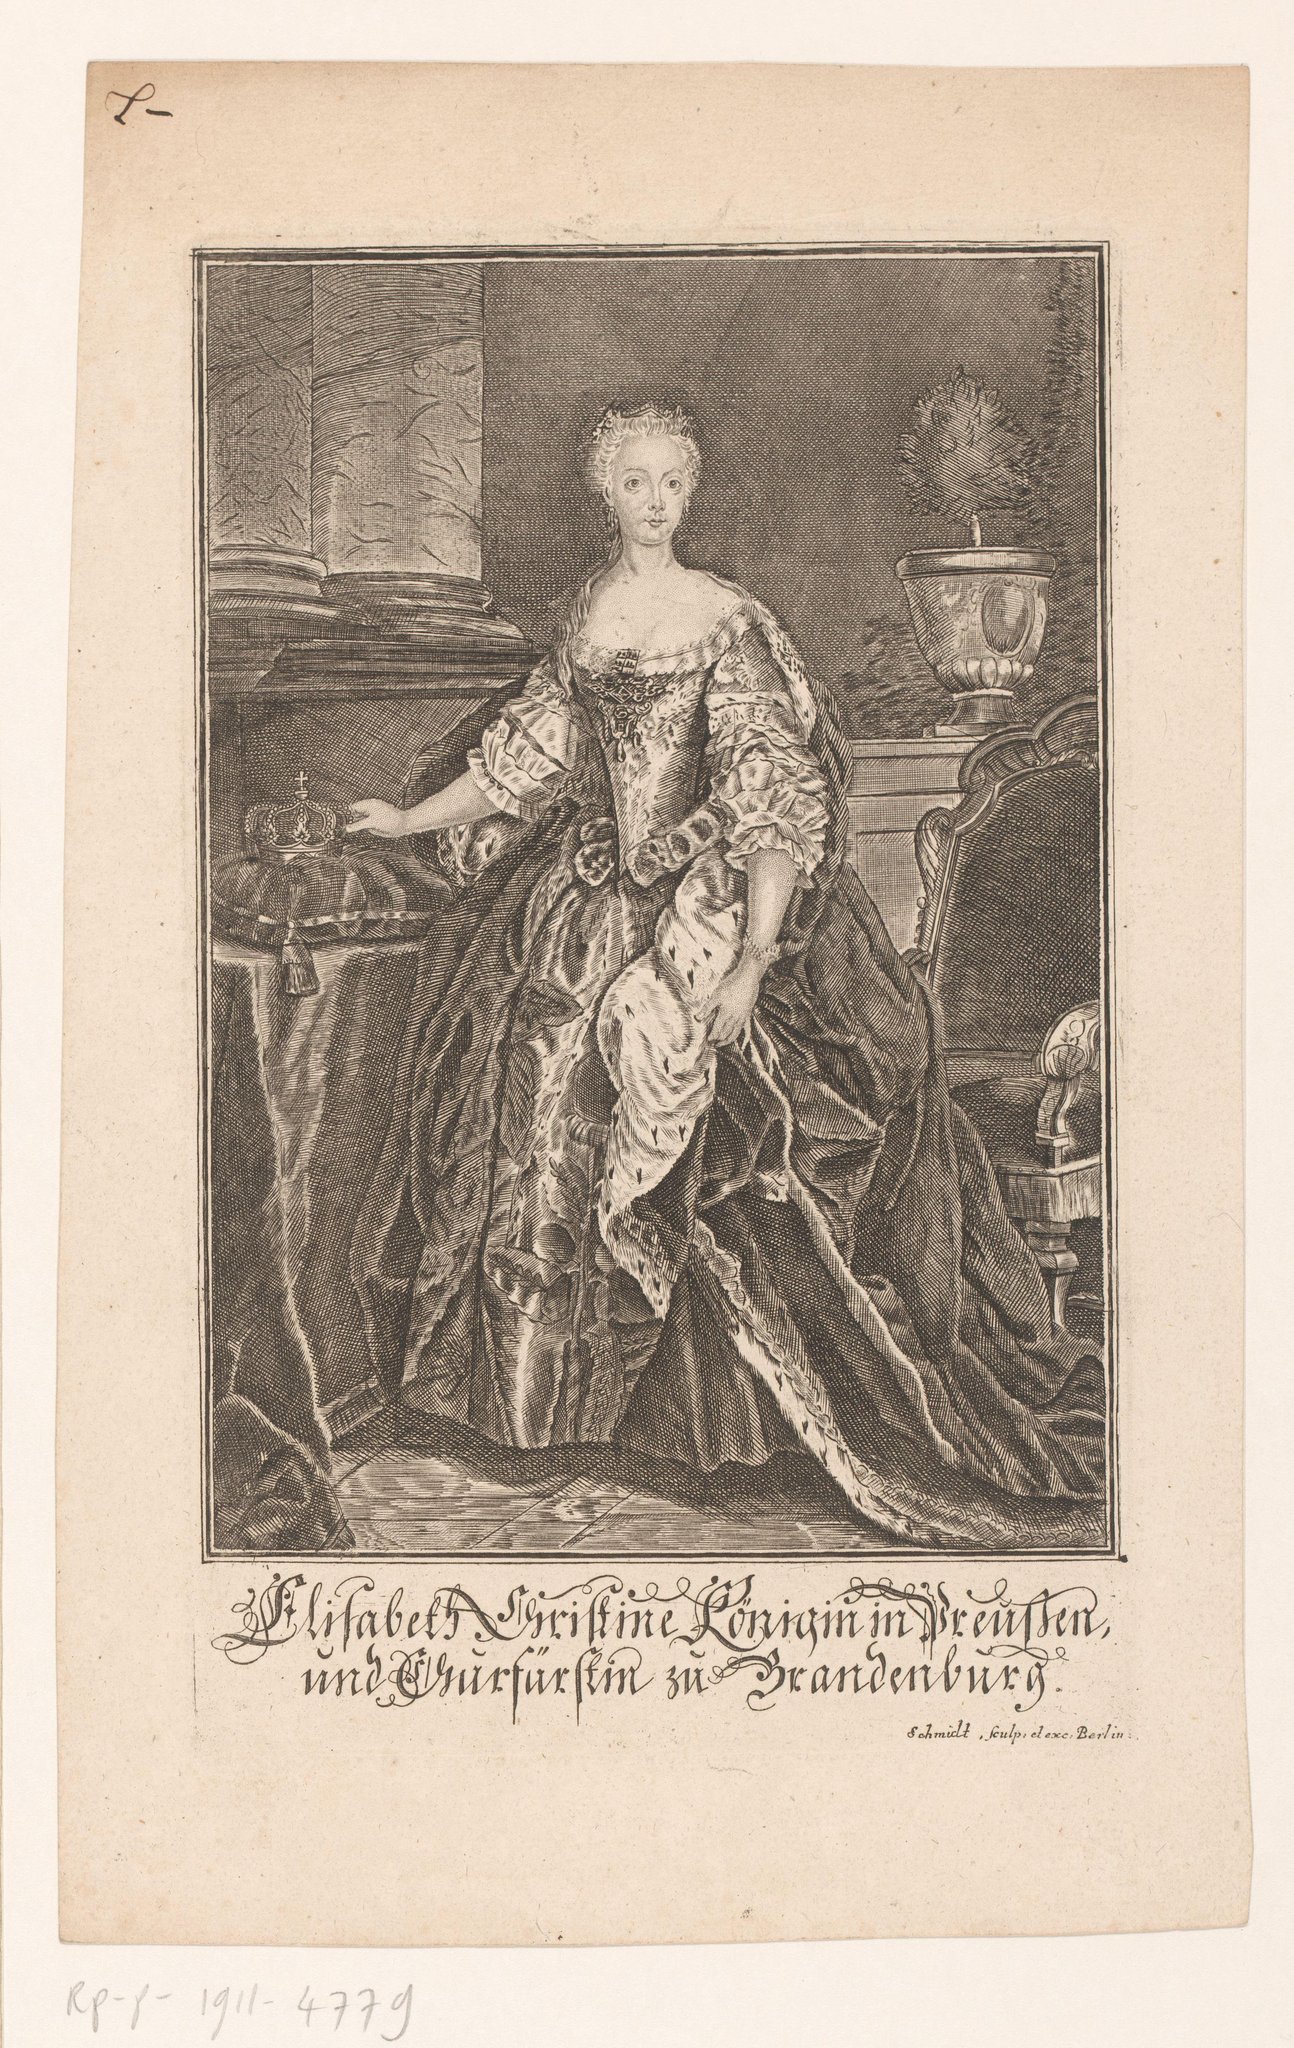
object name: print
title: Portret van Elisabeth Christine van Brunswijk-Bevern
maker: georg christoph schmidt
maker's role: print maker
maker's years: 1740-1811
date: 1750-1811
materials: paper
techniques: etching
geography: berlin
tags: historical persons - bb - woman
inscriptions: collector's mark: Lugt 2228